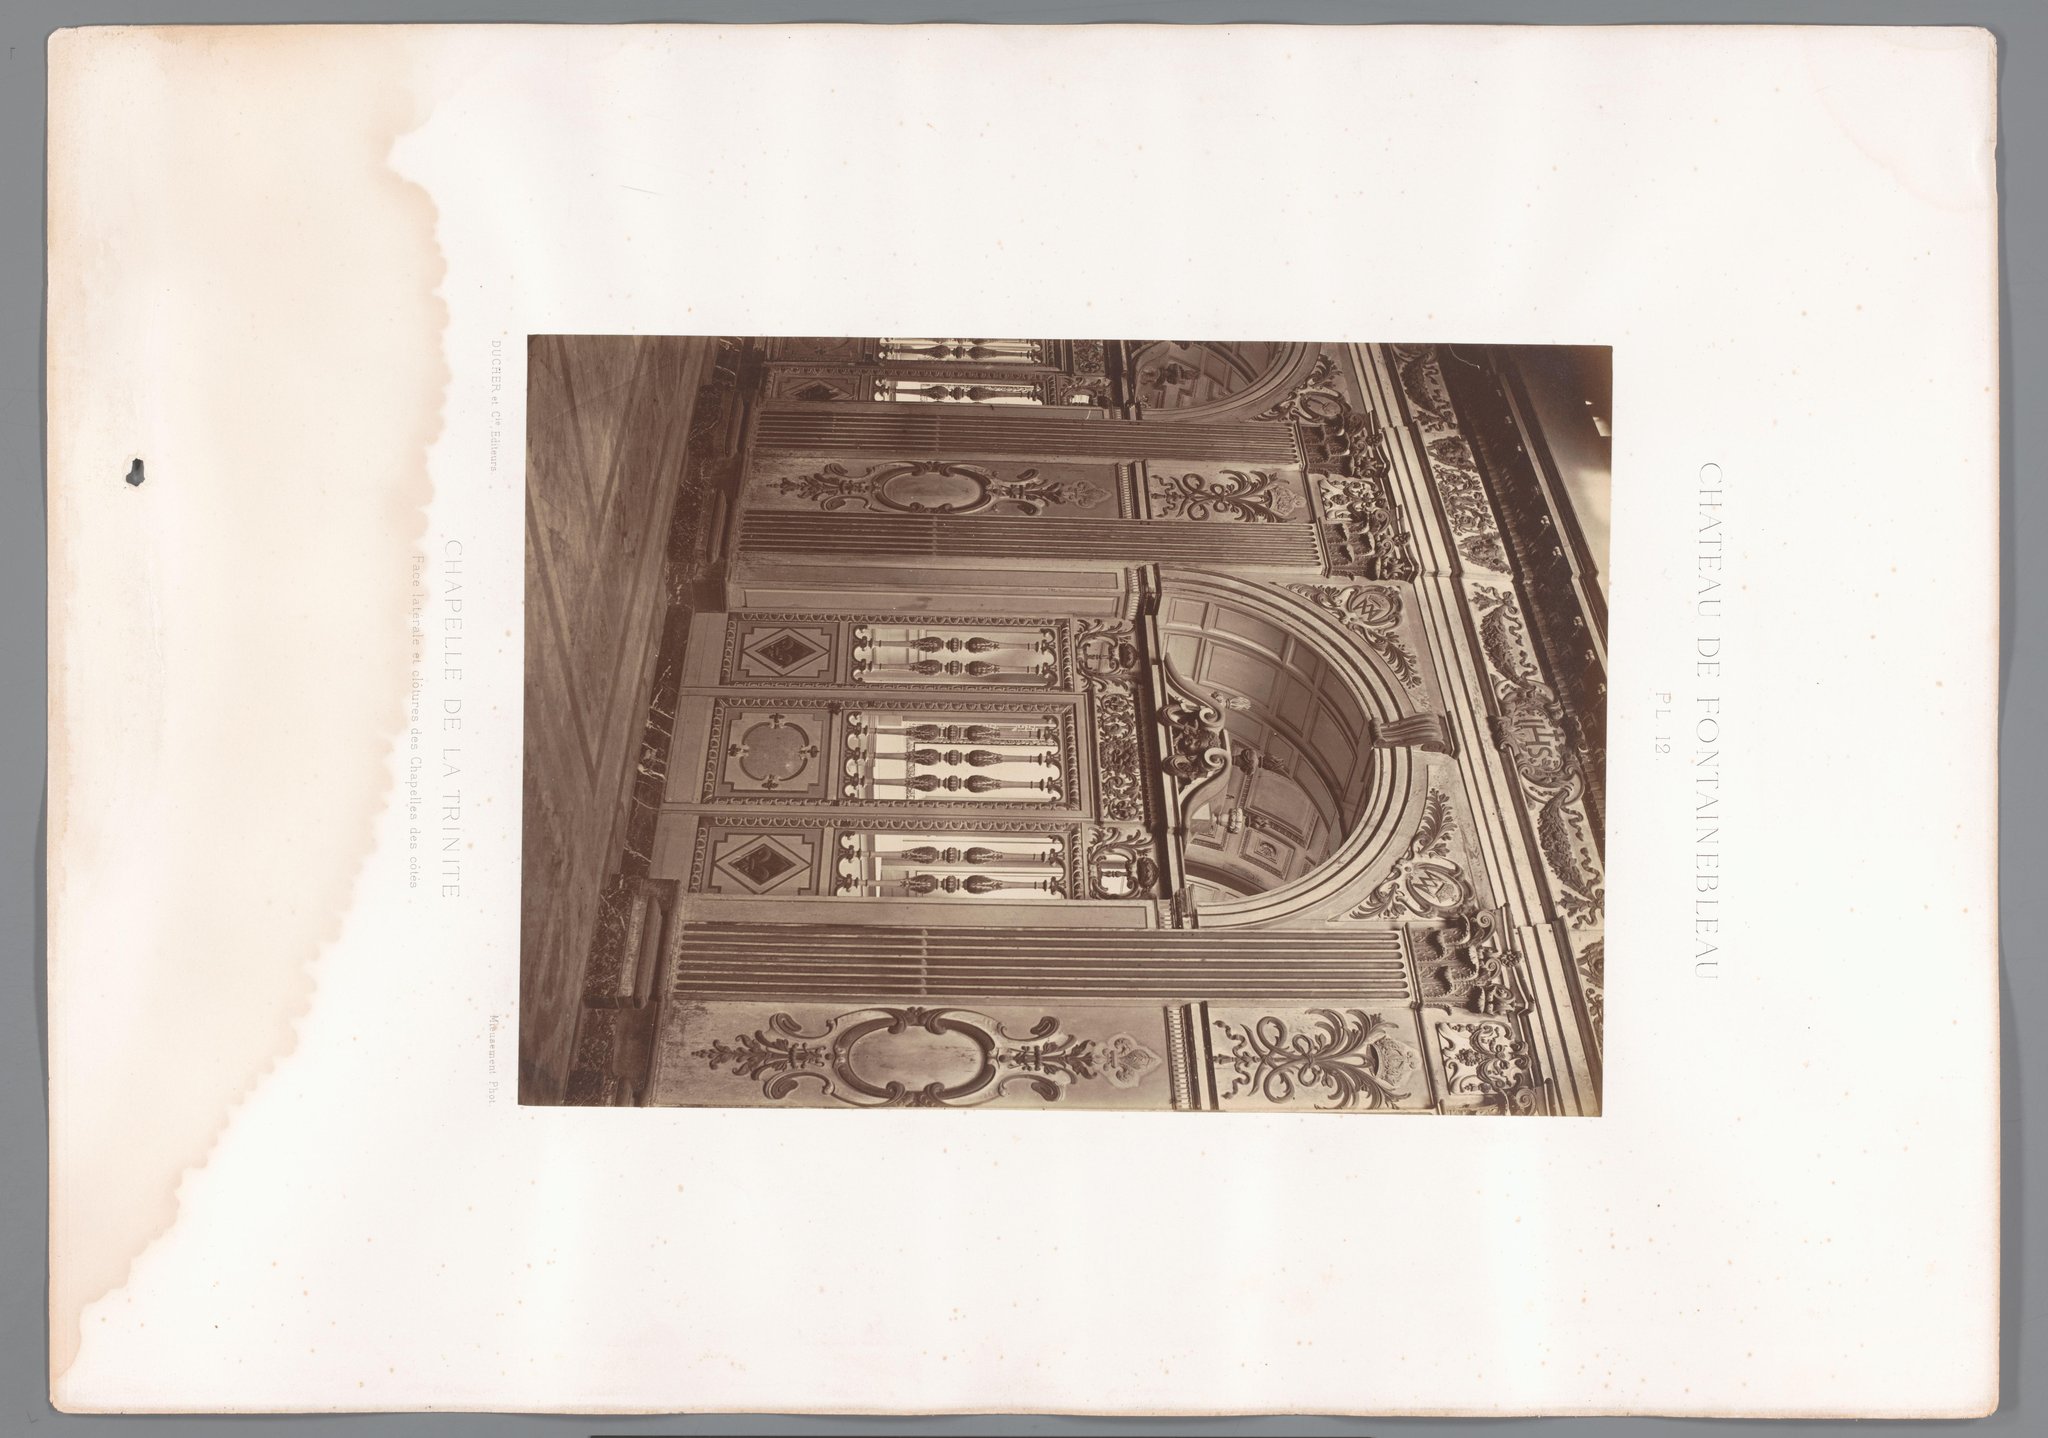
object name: photograph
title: Chapelle de la Trinité - Face Latérale et Clôtures des Chapelles des Côtés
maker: séraphin-médéric mieusement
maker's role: fotograaf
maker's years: 1840-1905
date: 1870-1875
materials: photographic support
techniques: albumen print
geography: fontainebleau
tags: chapel (interior of the house), castle - aa - civic architecture: inside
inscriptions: number: ‘PL. 12.’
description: Deze foto maakt deel uit van een omslag met dertig foto's en twee tekstbladen.